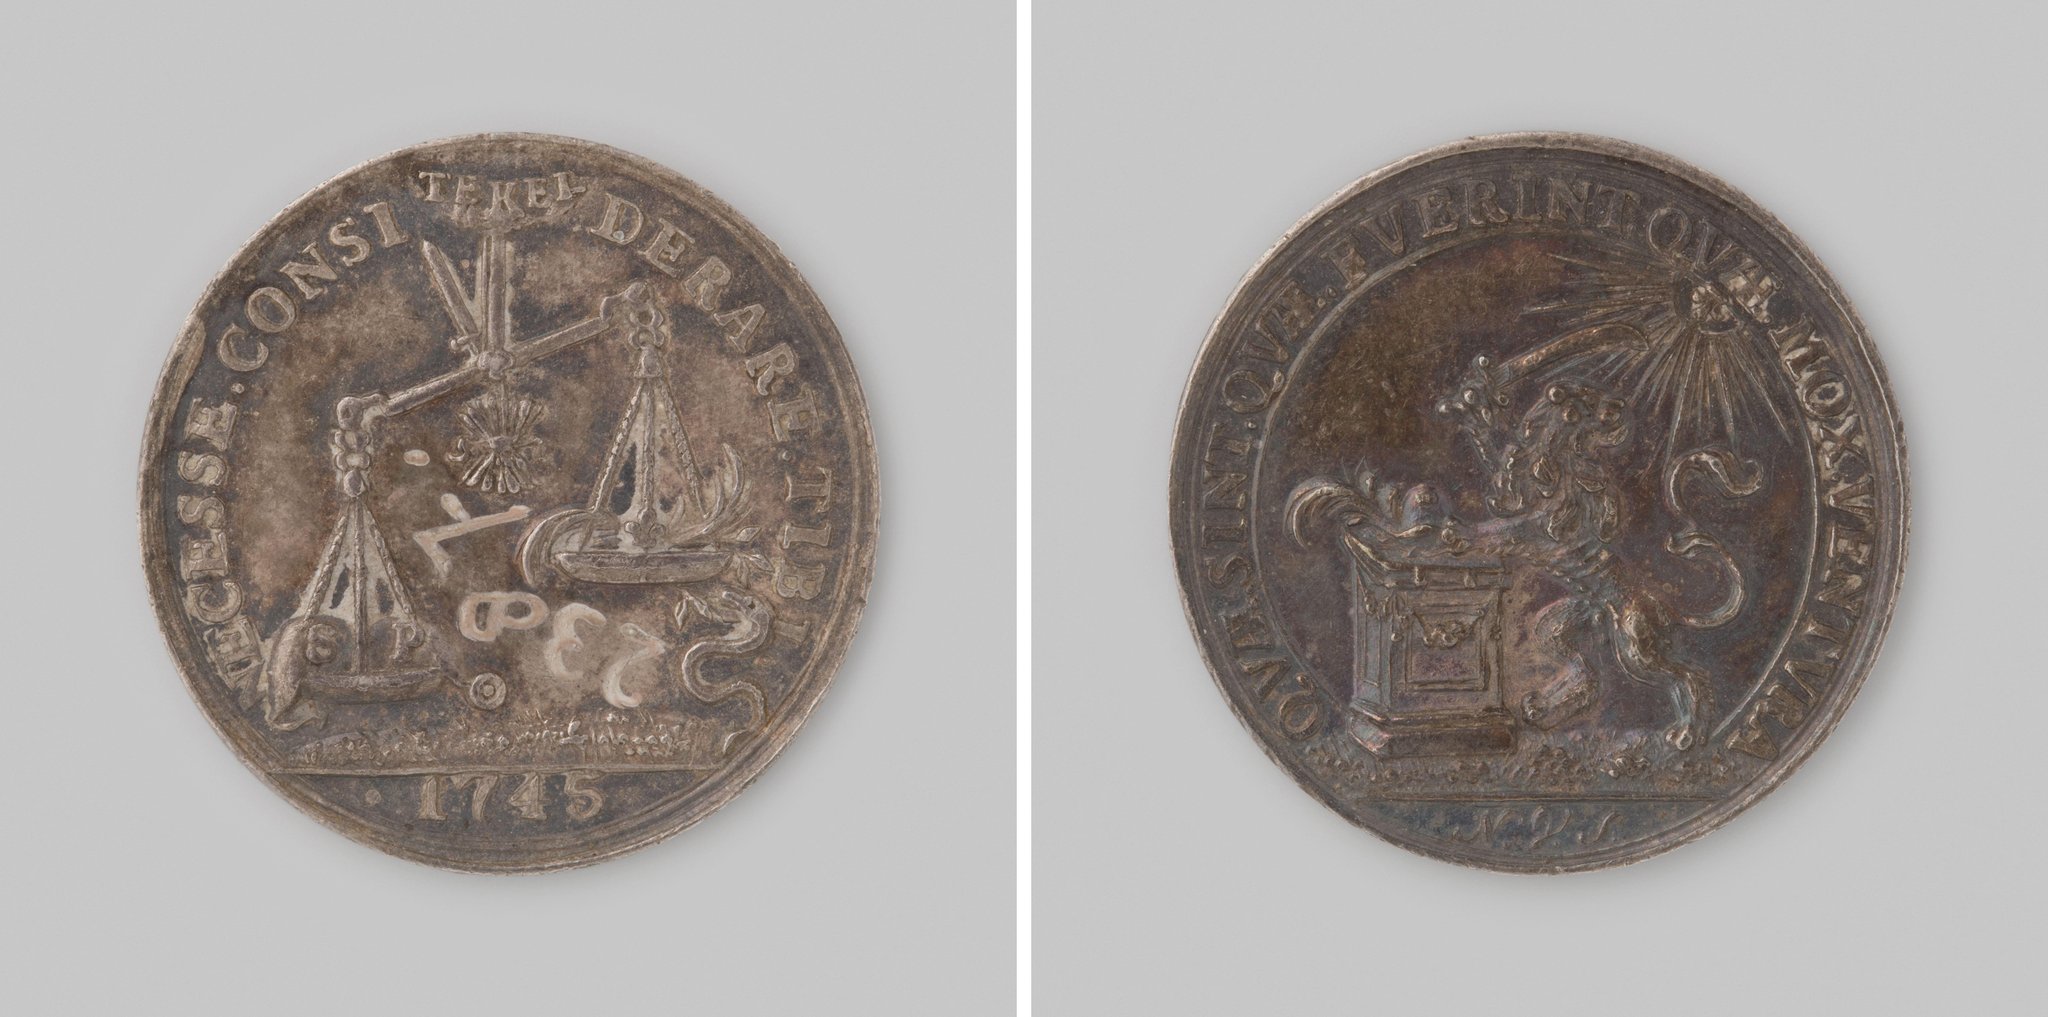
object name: history medal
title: Nieuwjaarspenning op de zorgelijke toestand in de Nederlanden 1745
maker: nicolaas van swinderen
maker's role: jeweler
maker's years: 1705-1760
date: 1745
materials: silver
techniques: striking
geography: the hague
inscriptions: number: ‘2387.’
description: Zilveren penning, op de voorzijde een balans uit de hemel waaraan een pijlenbundel hangt, een zwaard als wijzer, de rechter schaal met palmtak en lelie weegt minder dan de linker waarop een oorkonde gemerkt SP, met omschrift en in afsnede 1745, op de keerzijde de Nederlandse leeuw met zwaard bij een altaar waarop bijbel, vrijheidshoed en palmtak, omziend naar een stralende lelie, met omschrift.